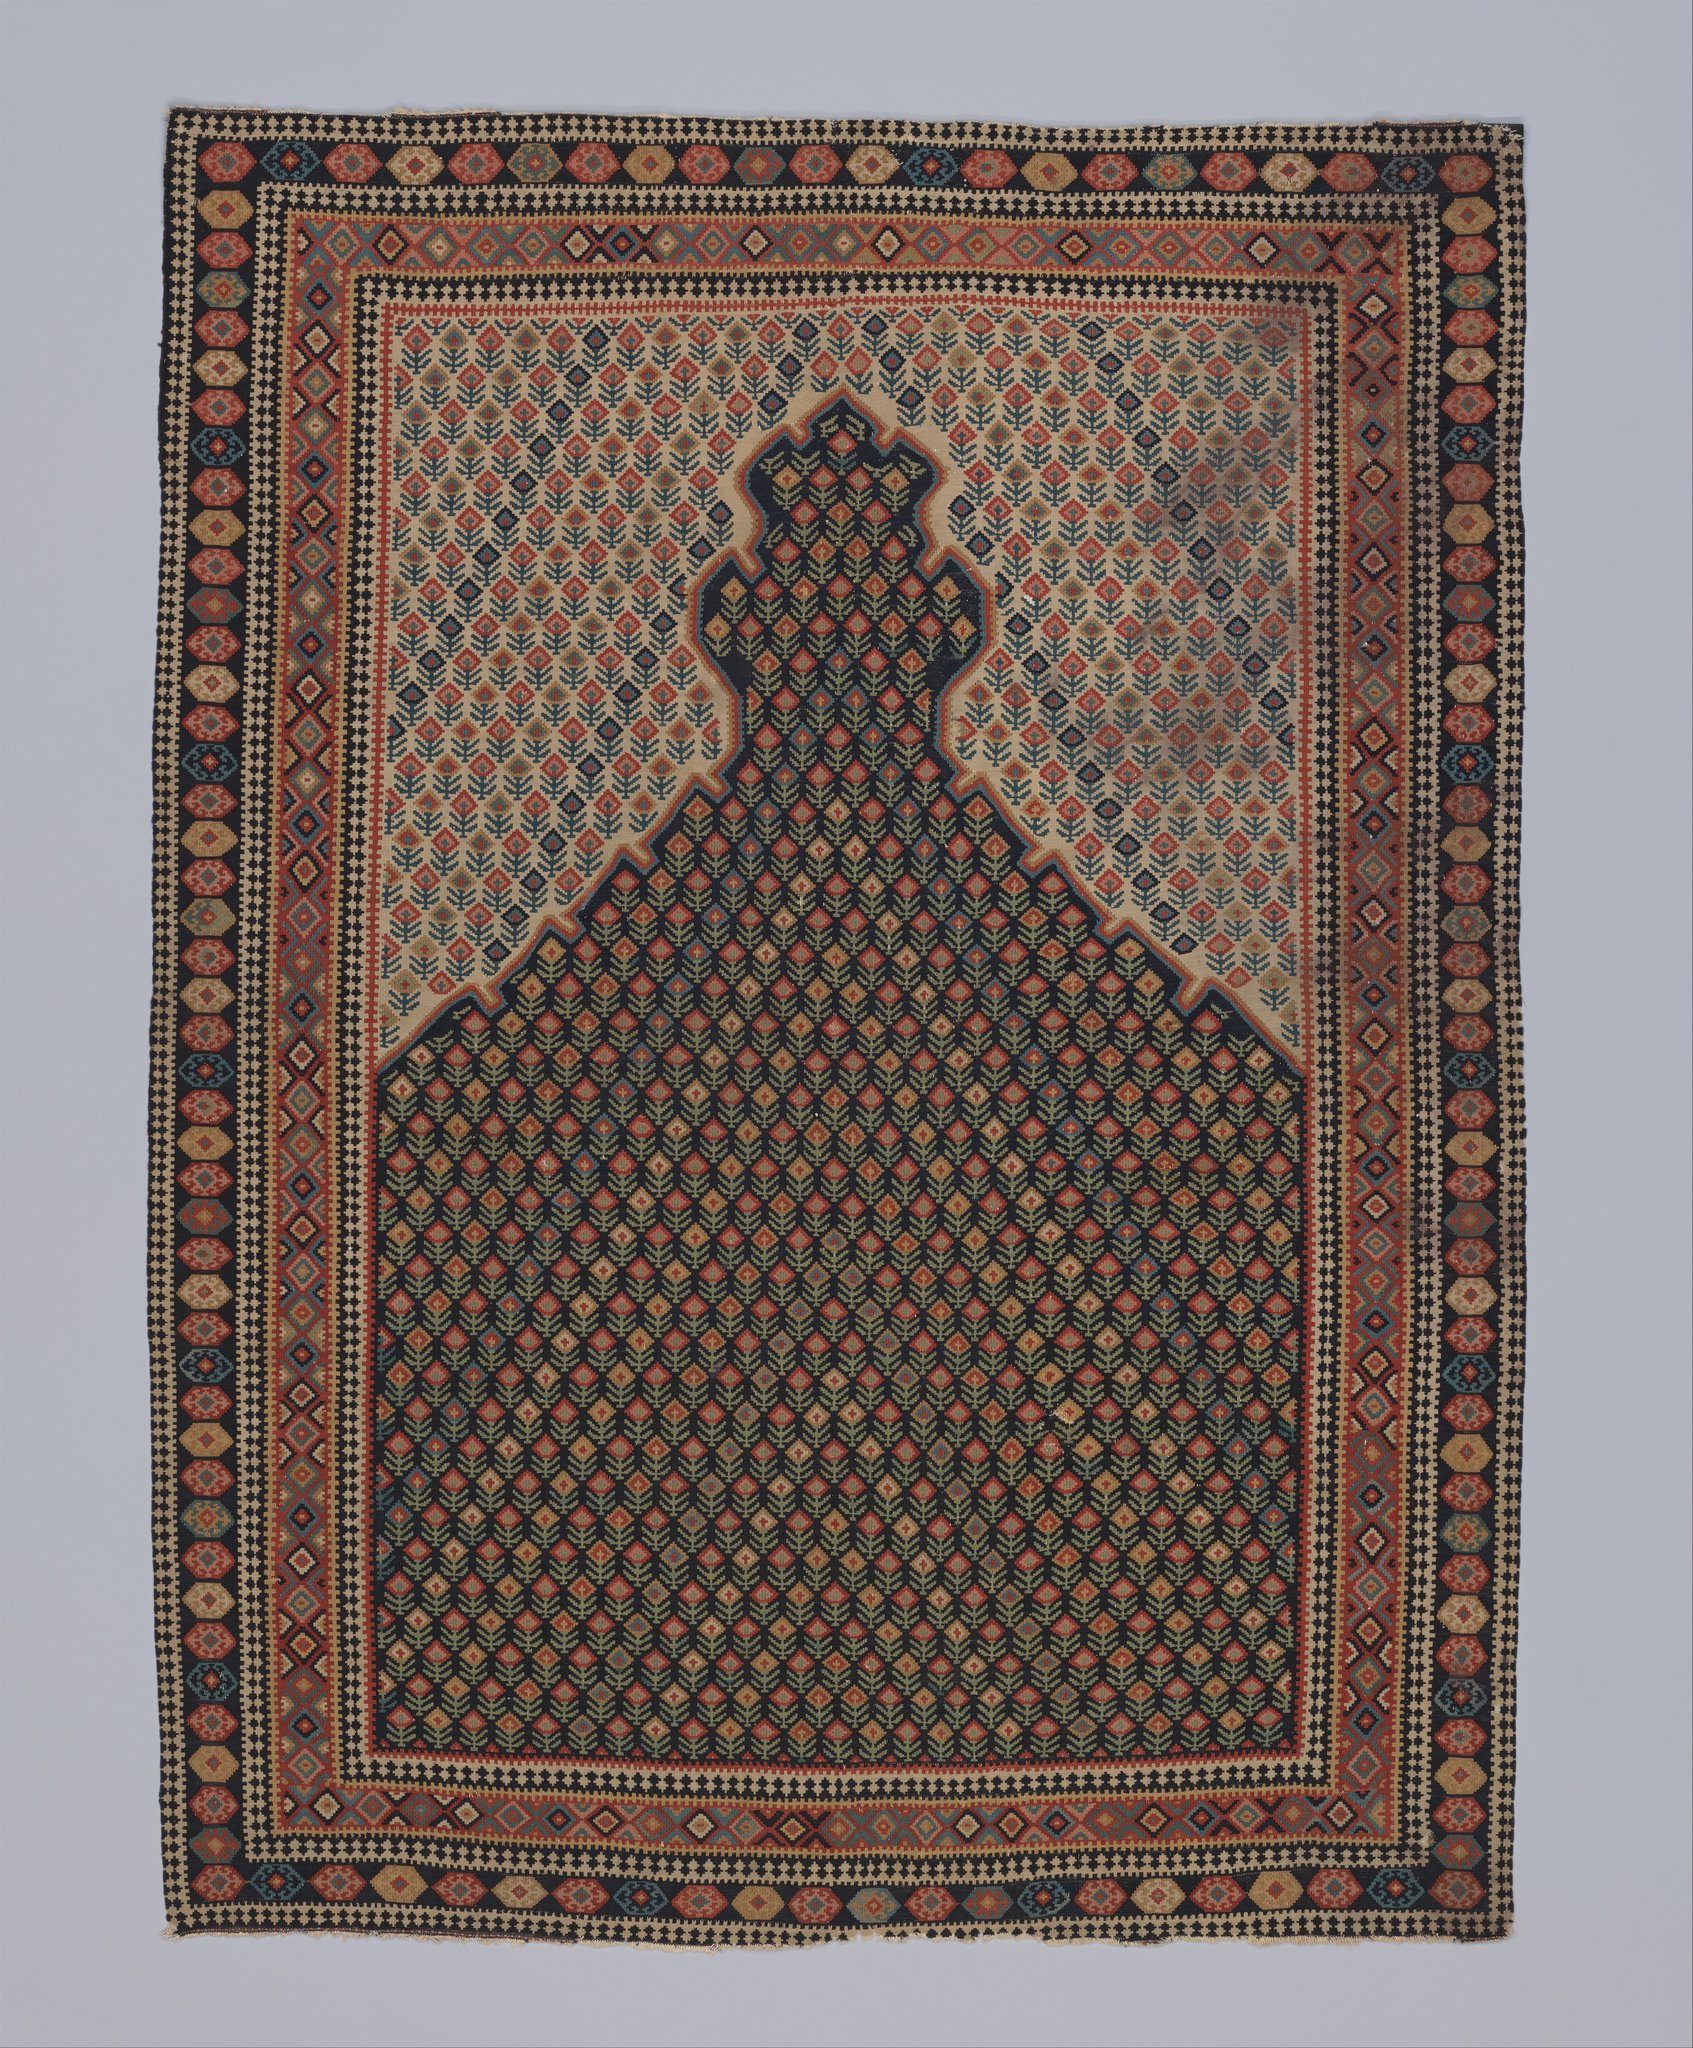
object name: carpet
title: "Senneh" Prayer Rug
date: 1767-1833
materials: cotton, wool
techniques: tapestry, weave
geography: northwestern iran